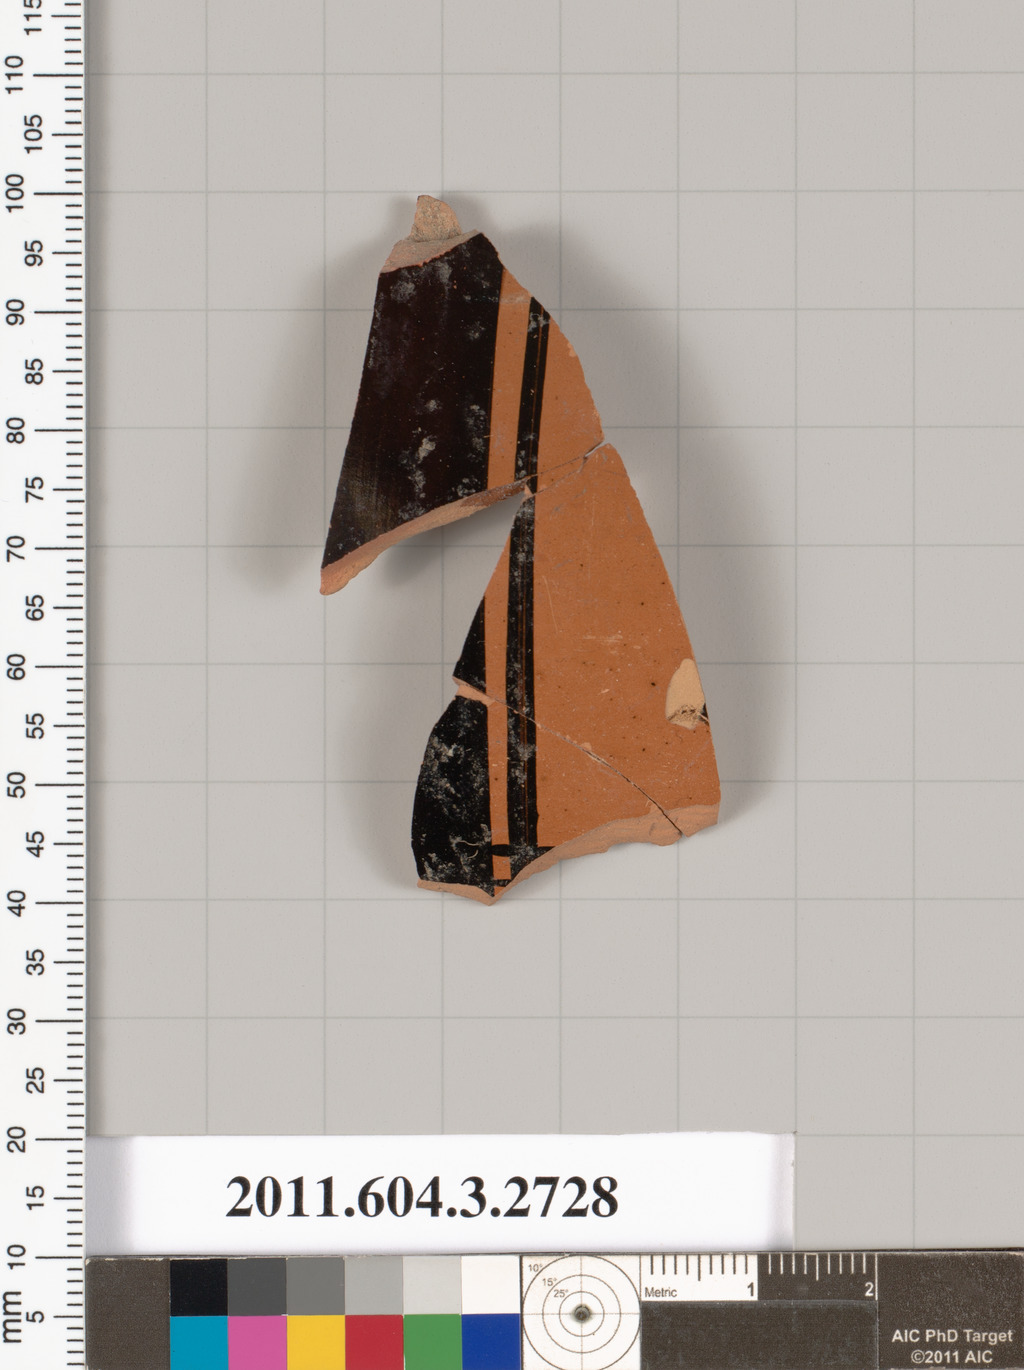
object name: oinochoe fragment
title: Terracotta fragment of an oinochoe (jug)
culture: greek, attic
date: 534-468 BCE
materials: terracotta